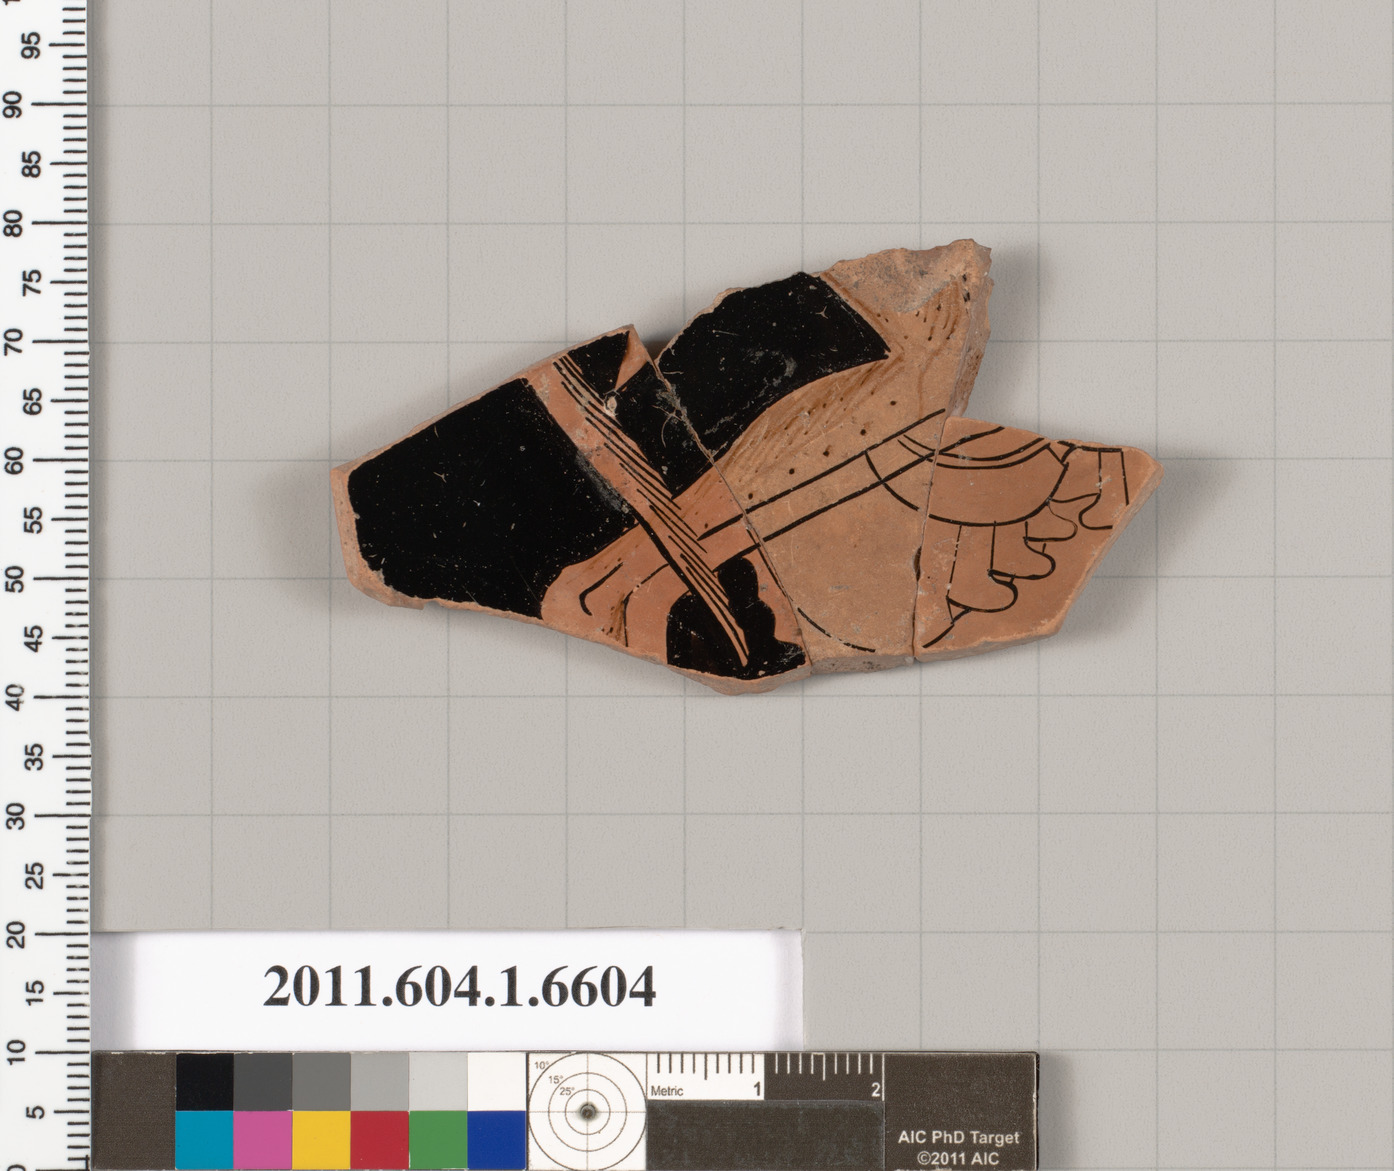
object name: kylix fragment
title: Terracotta fragment of a kylix (drinking cup)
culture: greek, attic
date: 490-480 BCE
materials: terracotta